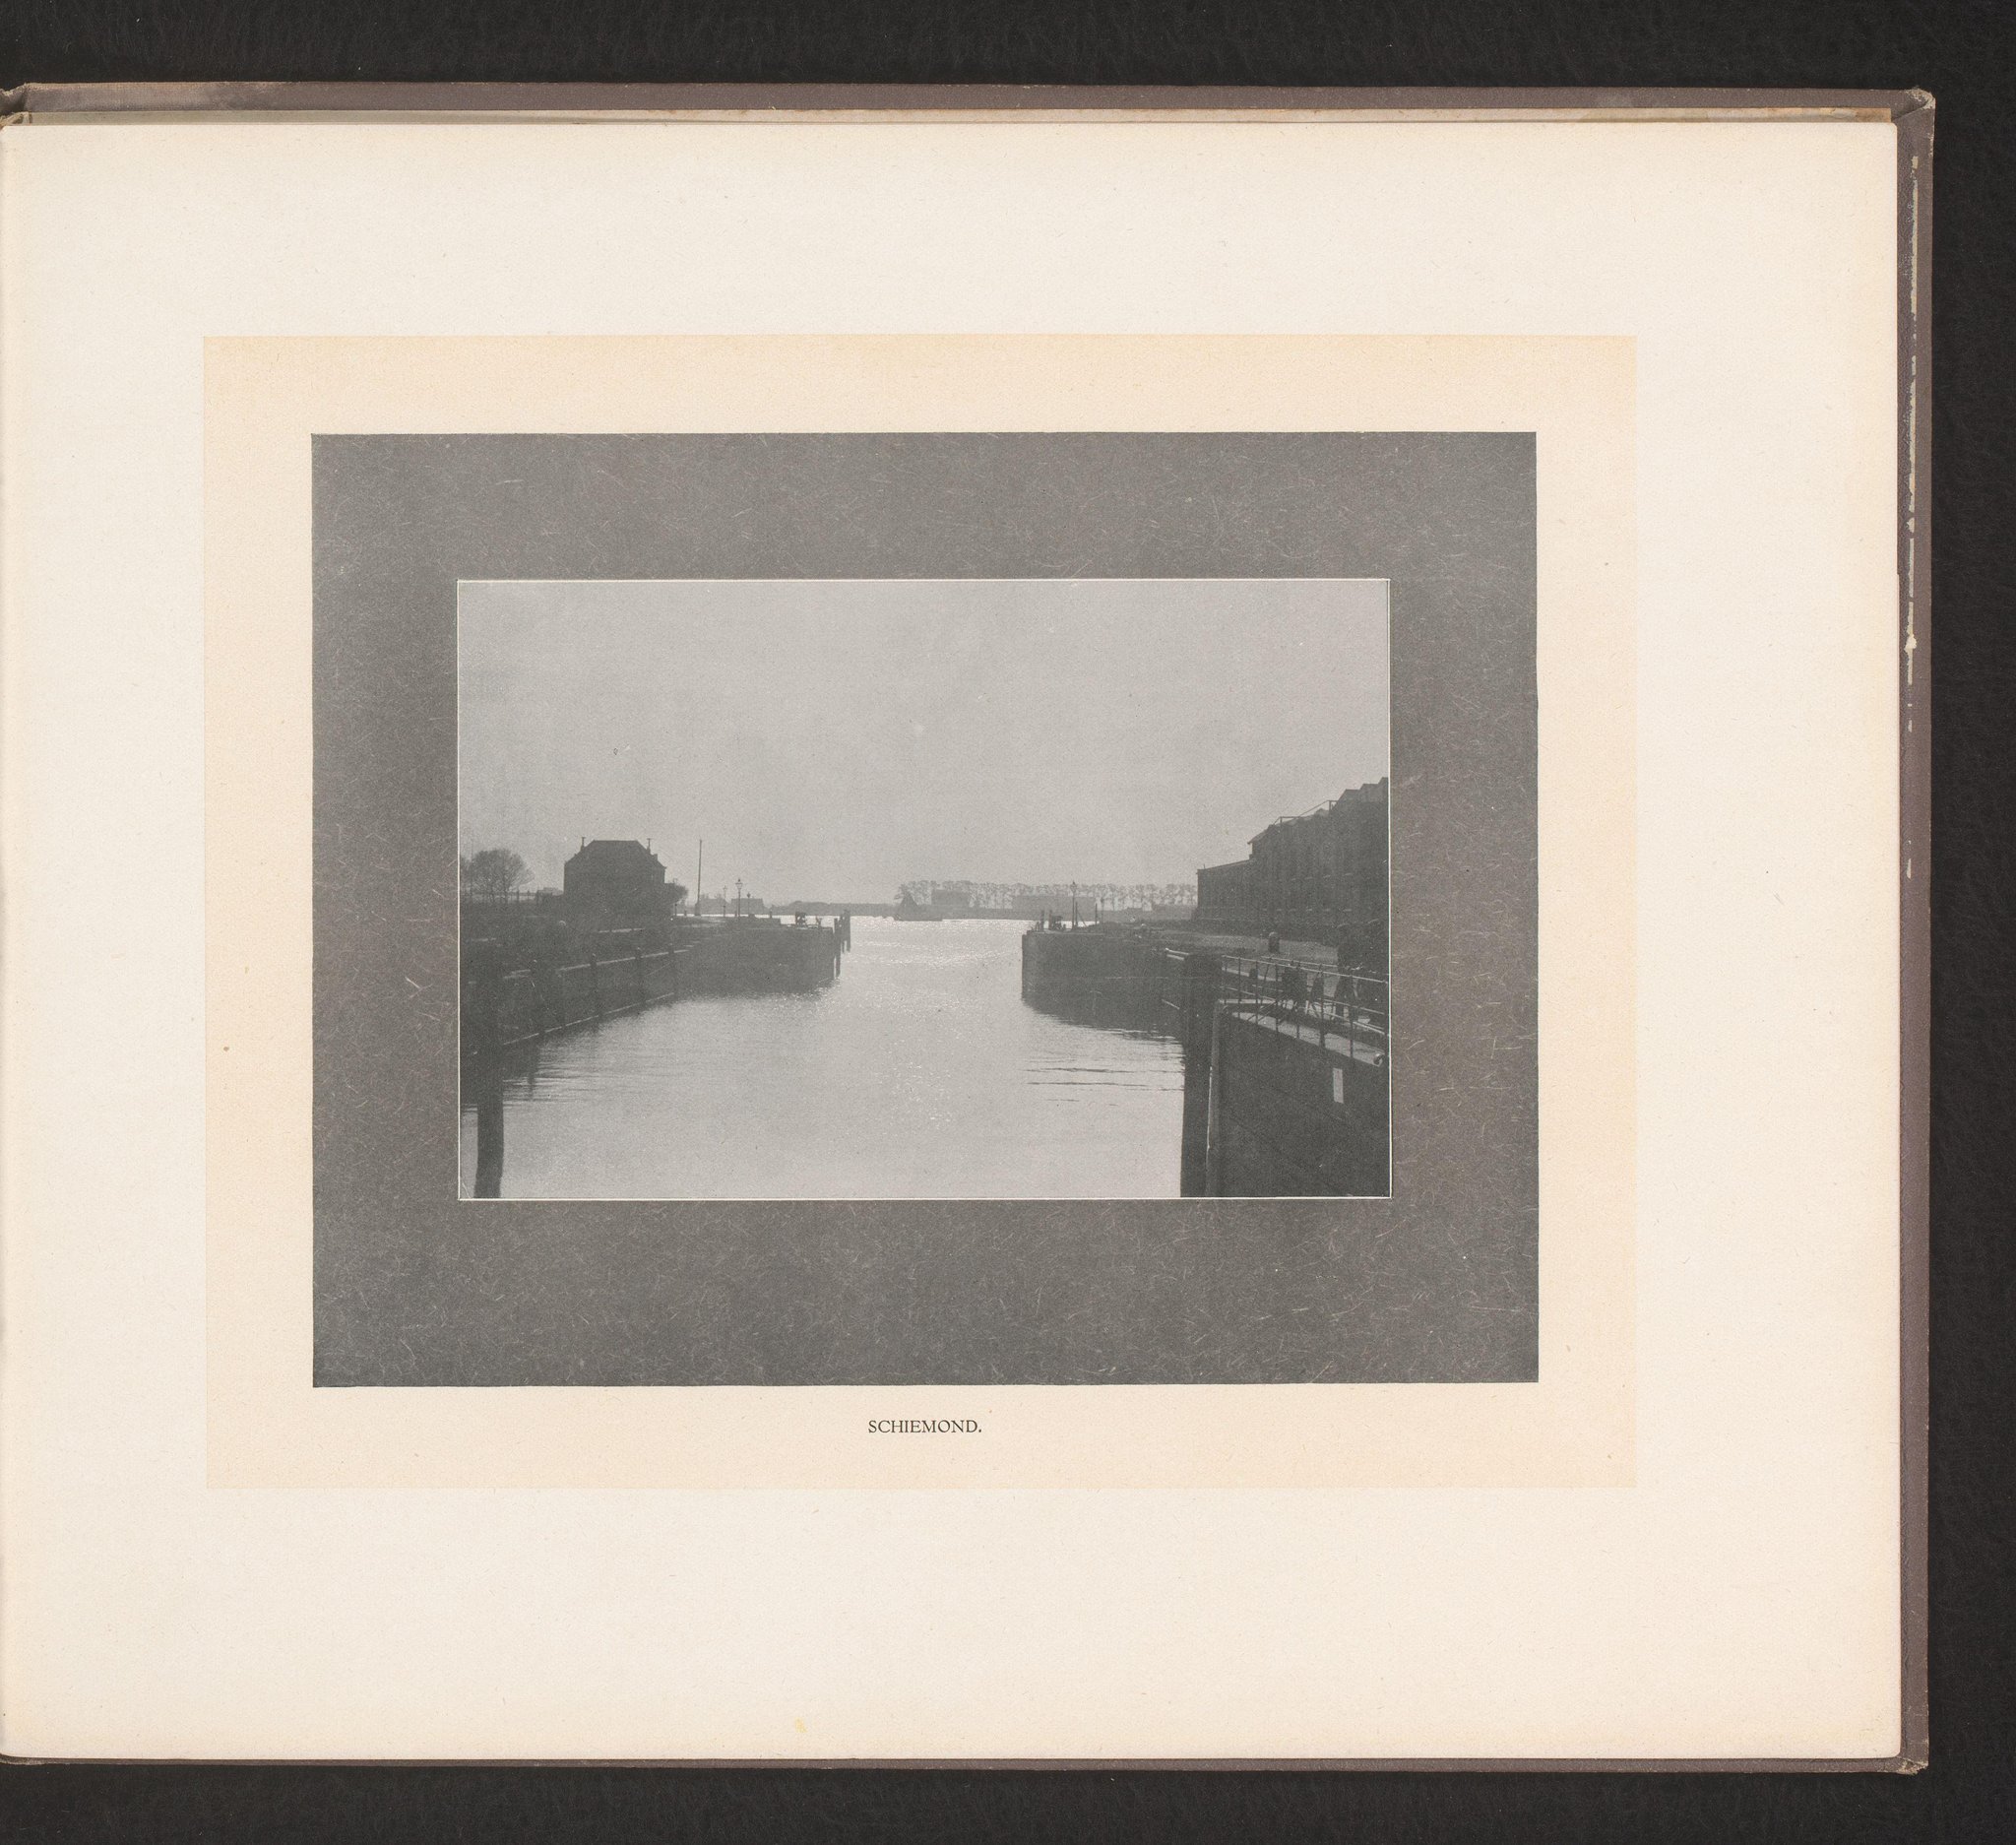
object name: photomechanical print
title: Gezicht op Schiemond te Rotterdam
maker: Anonymous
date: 1908-1913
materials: paper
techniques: autotype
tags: harbour, river, rotterdam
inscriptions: inscription: ‘Schiemond’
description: Deze prent maakt deel uit van een album.